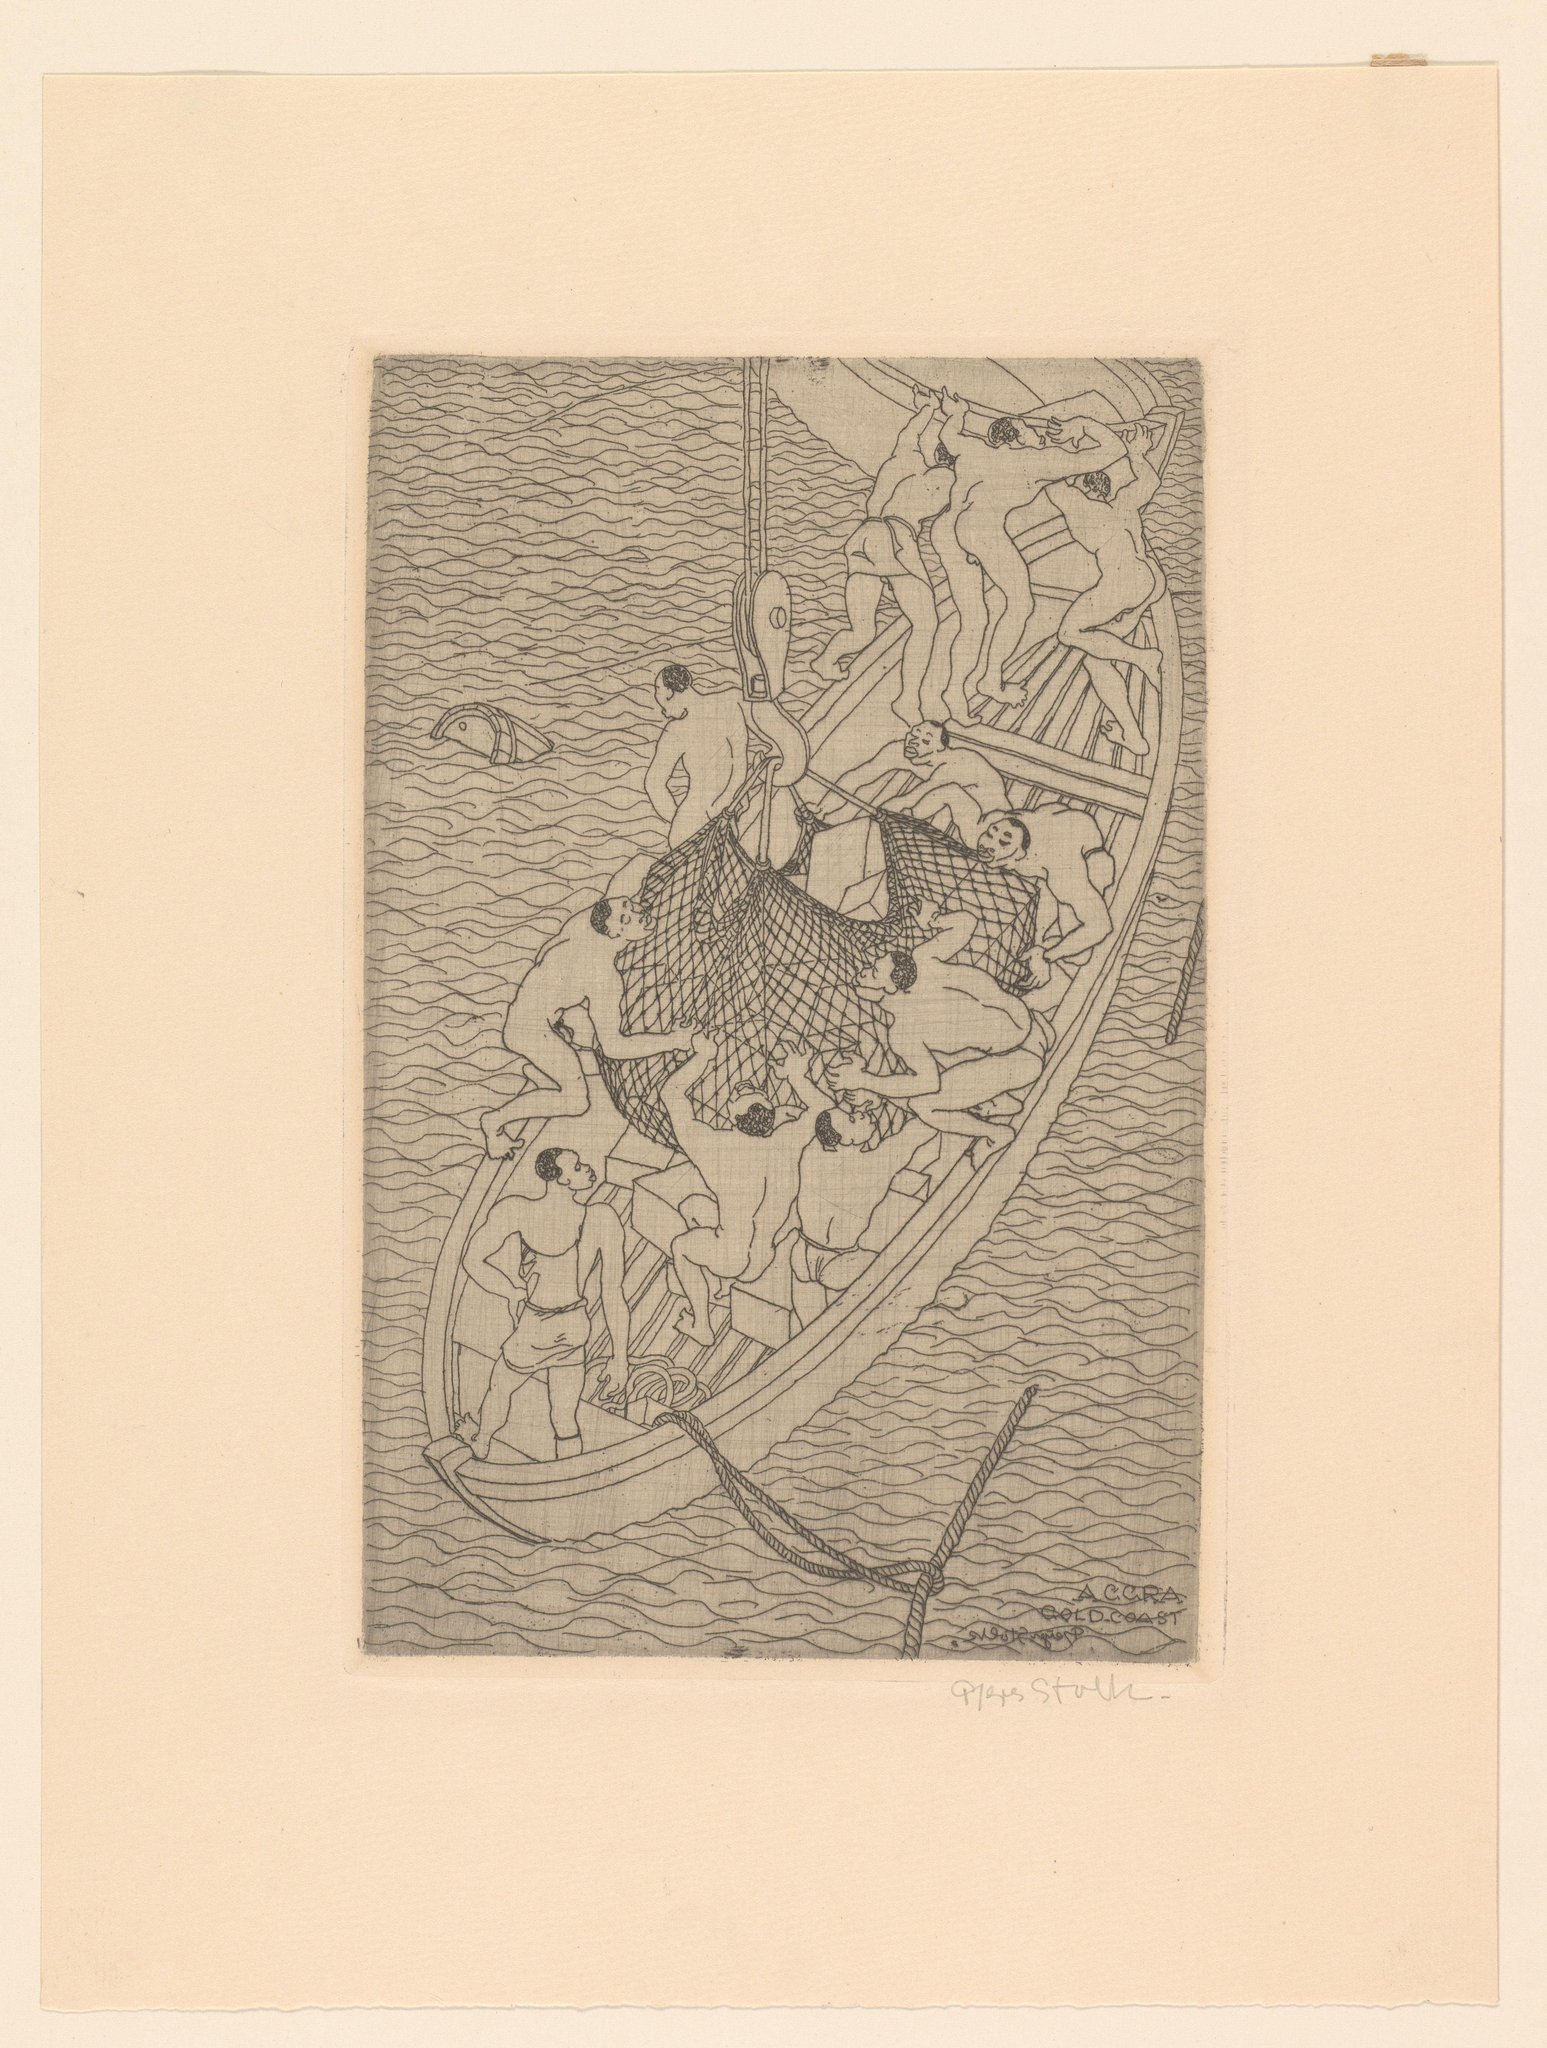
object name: print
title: De Goudkust en Nigeria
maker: reijer stolk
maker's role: draughtsman, print maker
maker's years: 1896-1945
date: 1931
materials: paper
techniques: drypoint, etching, intaglio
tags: rowing-boat, canoe, etc., dock crane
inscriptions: collector's mark: Lugt 2228